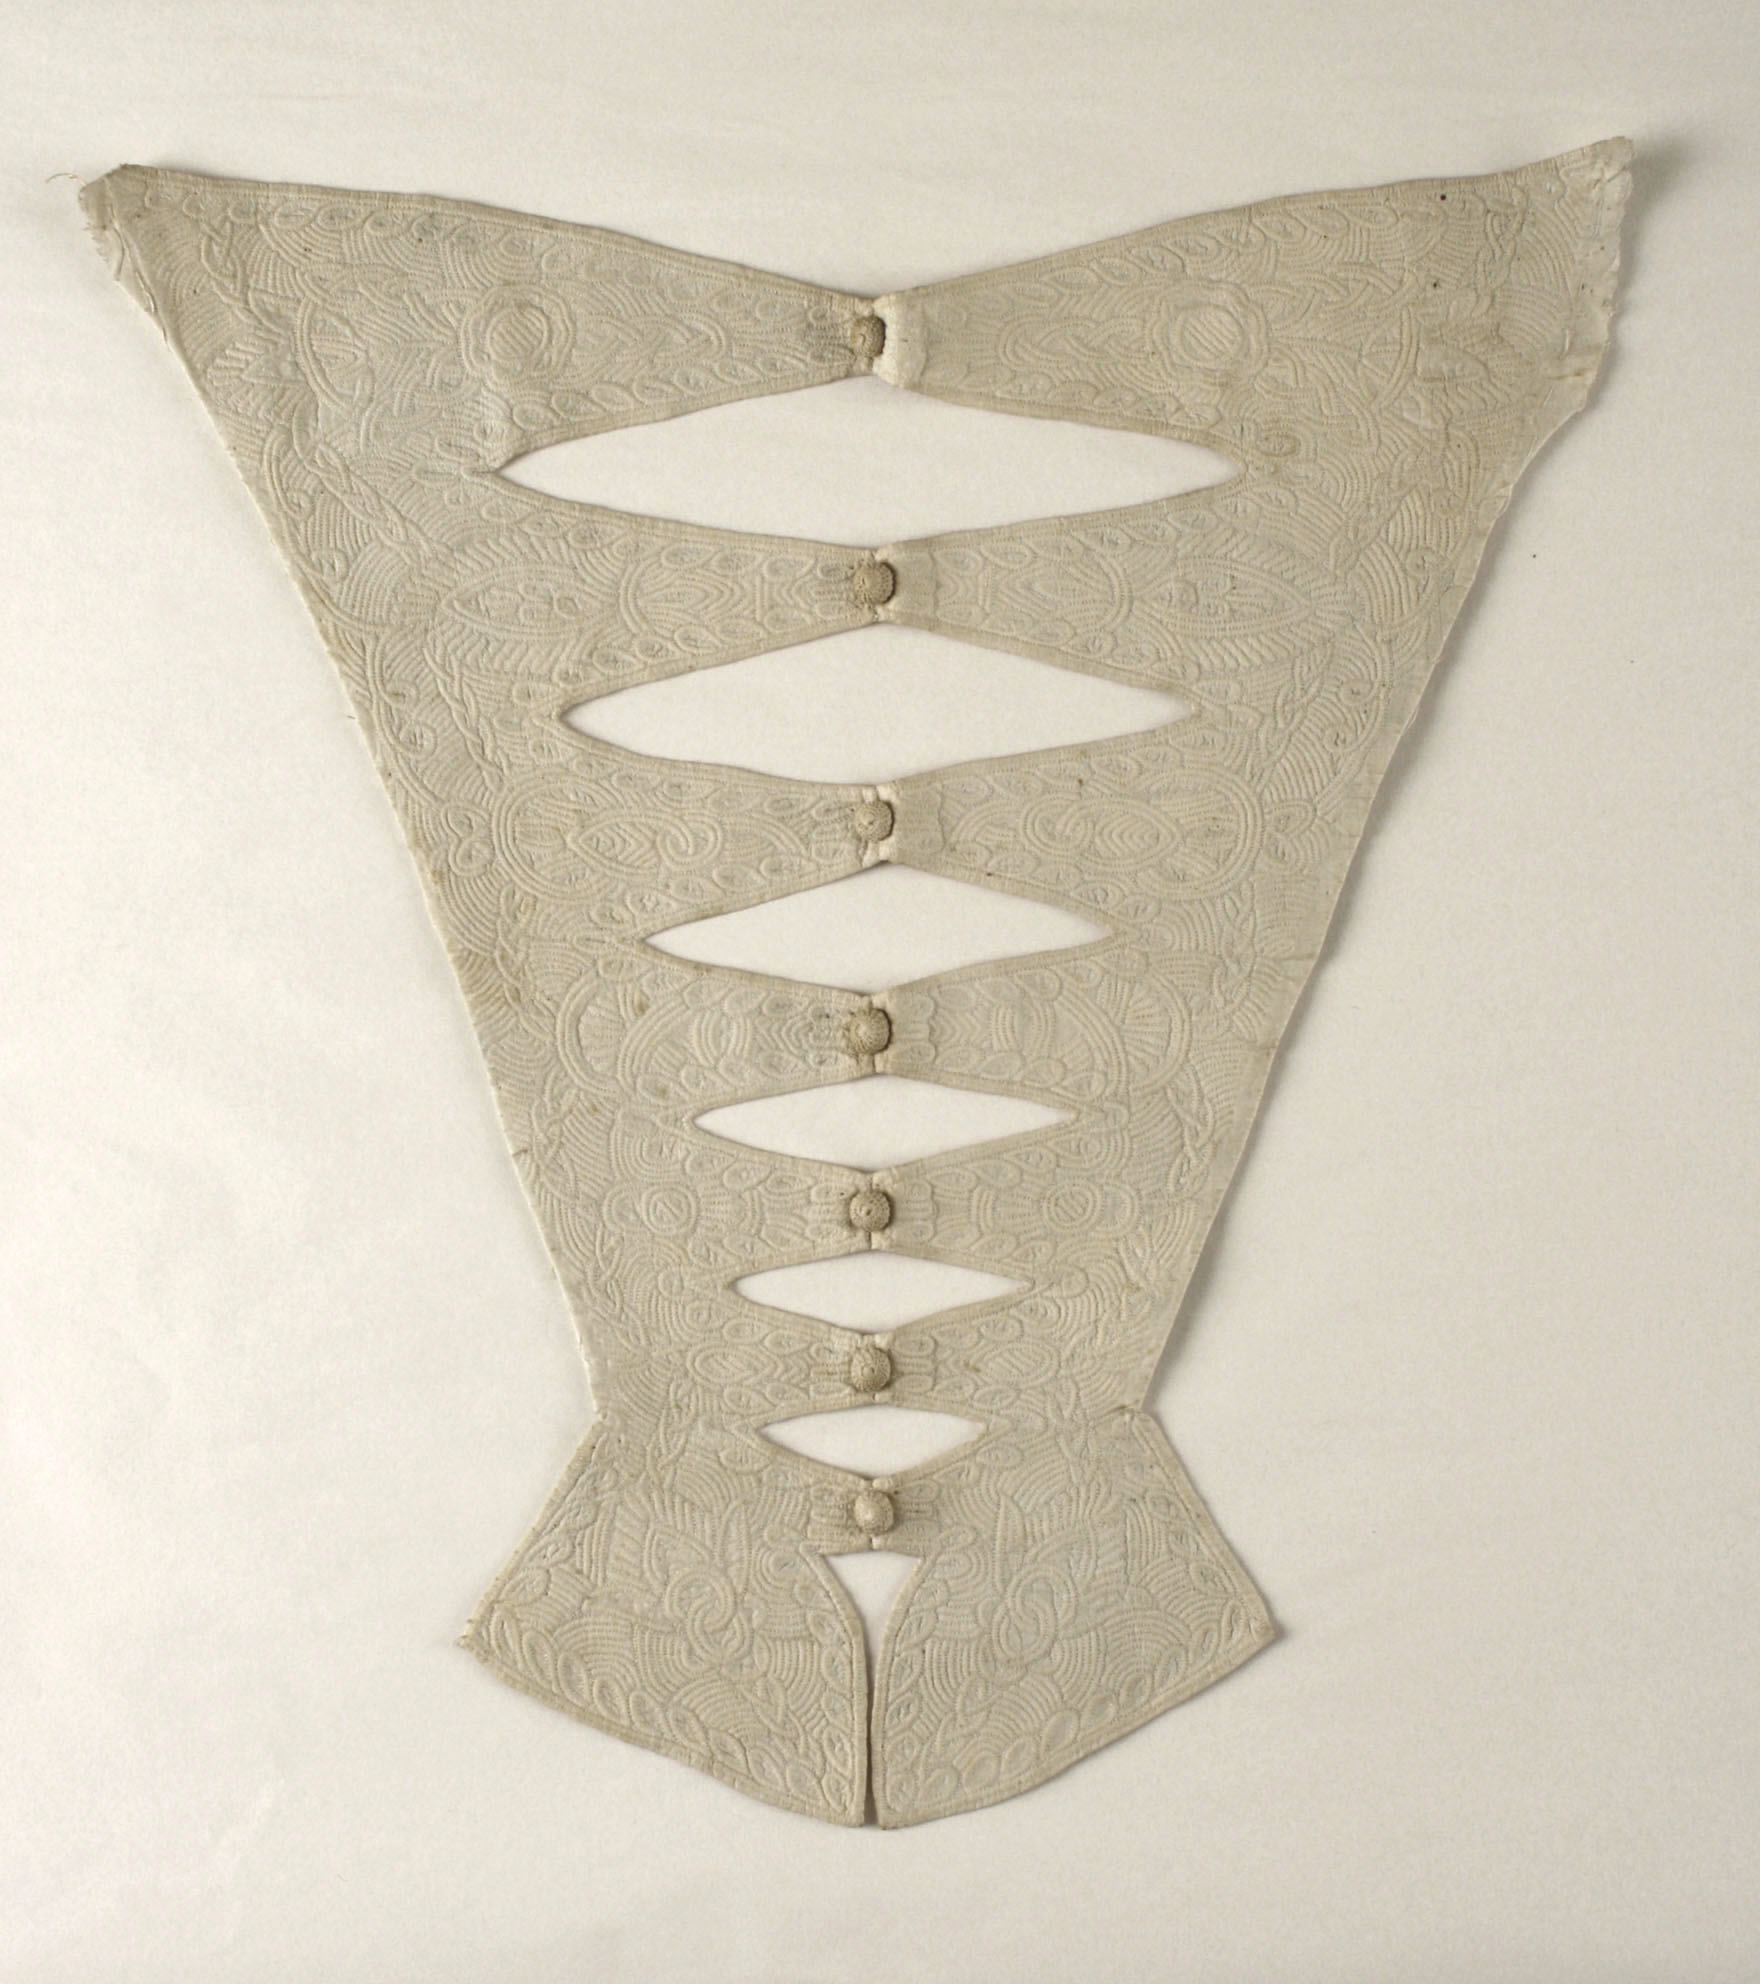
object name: stomacher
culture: british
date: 1700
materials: cotton